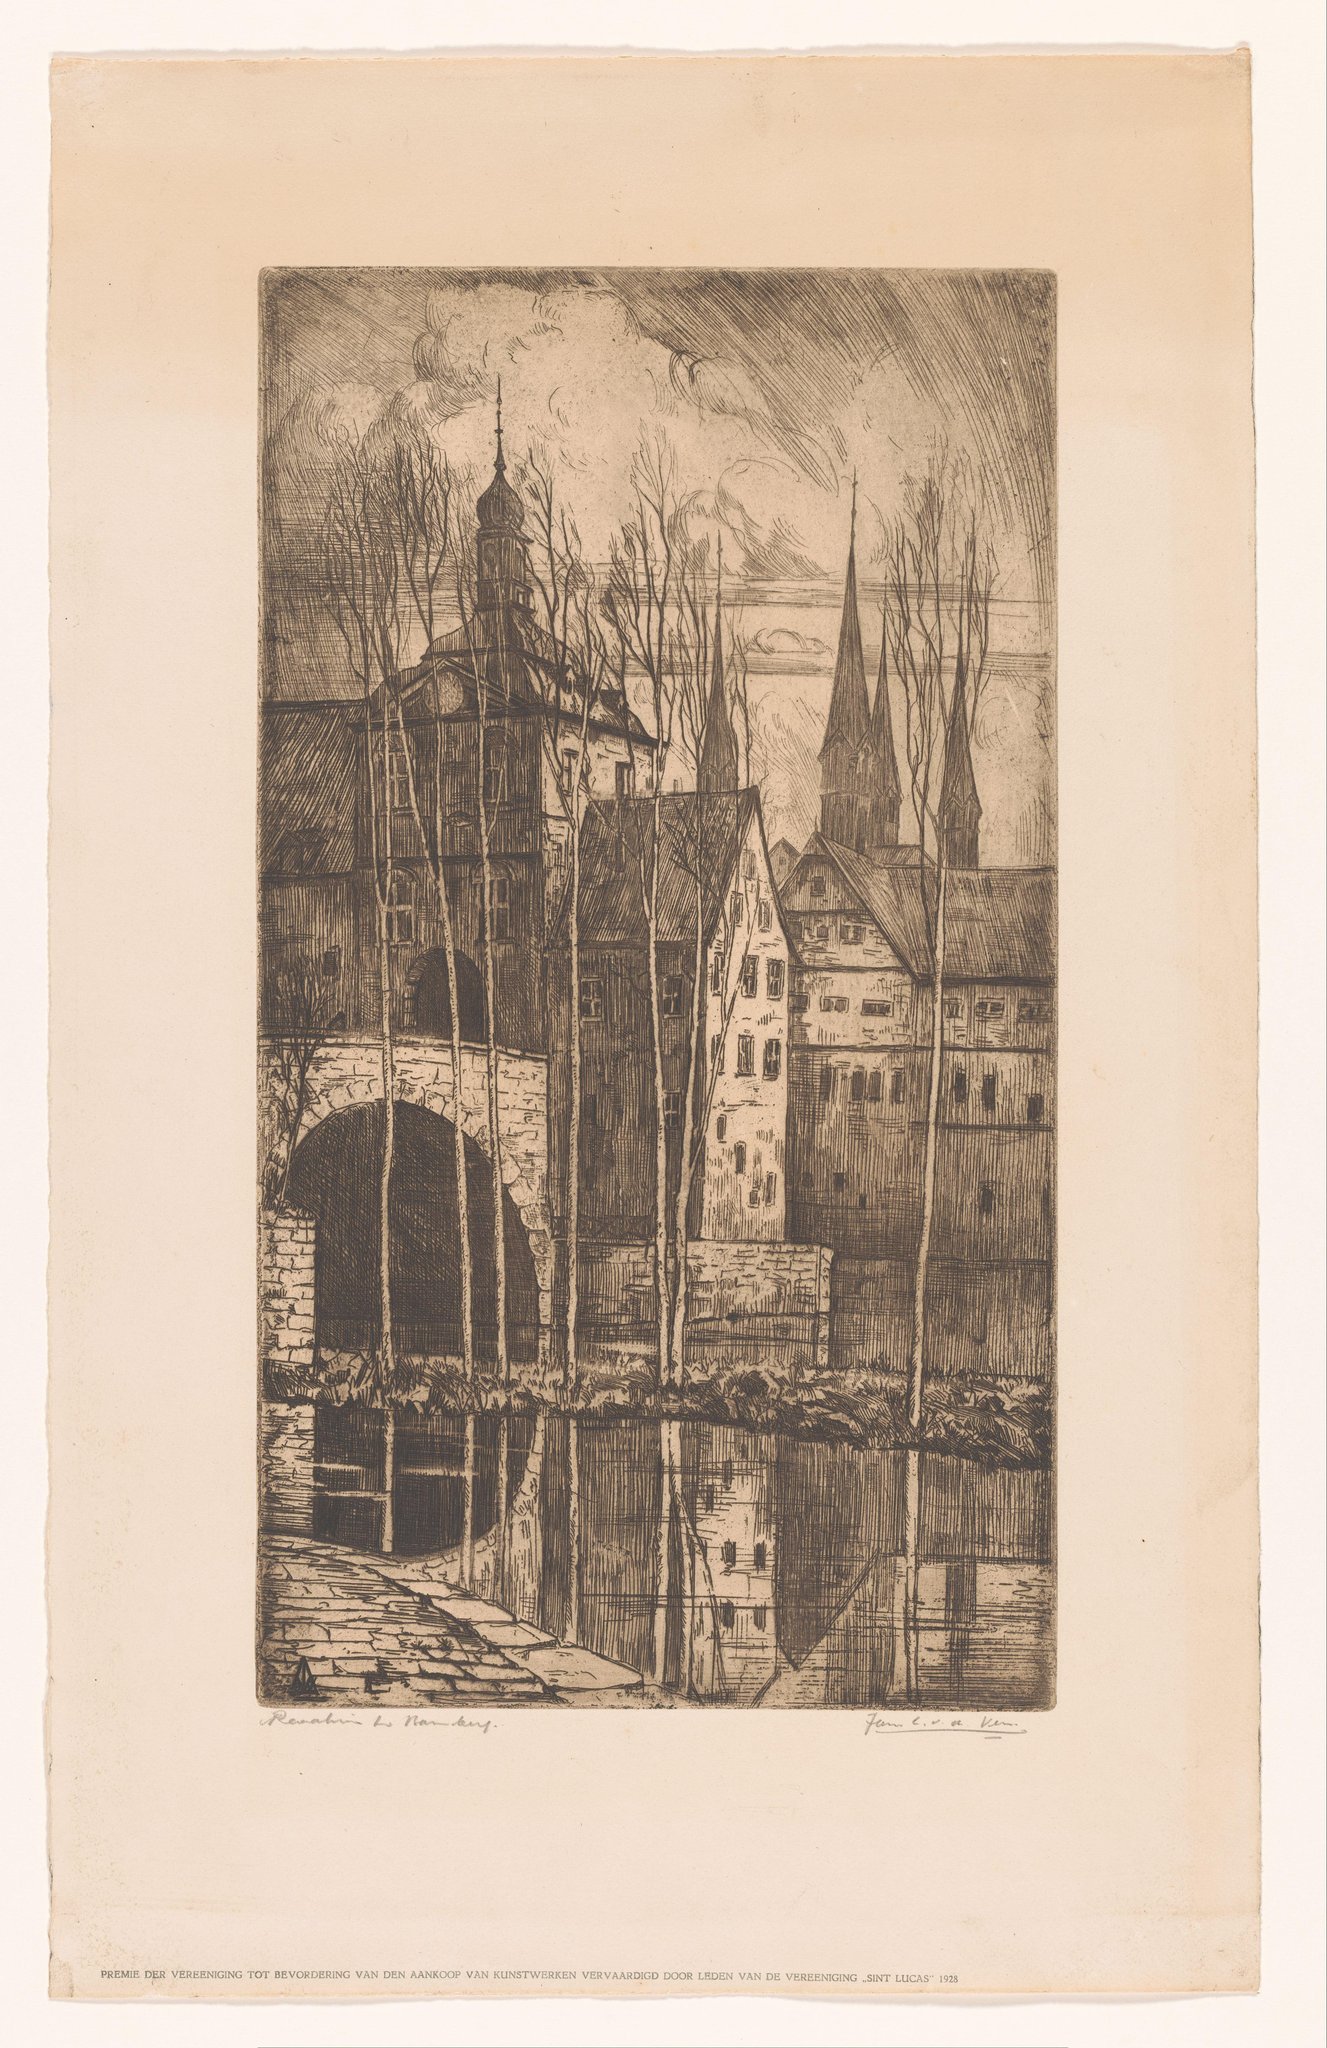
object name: print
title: Raadhuis te Bamberg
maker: jan c. van der ven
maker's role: draughtsman, print maker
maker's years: 1896-1930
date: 1928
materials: paper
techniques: etching, intaglio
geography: amsterdam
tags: city-view in general; 'veduta', townhall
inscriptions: collector's mark: Lugt 2228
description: De prent is als premie voor het jaar 1928 uitgegeven door de Vereniging Sint Lucas.